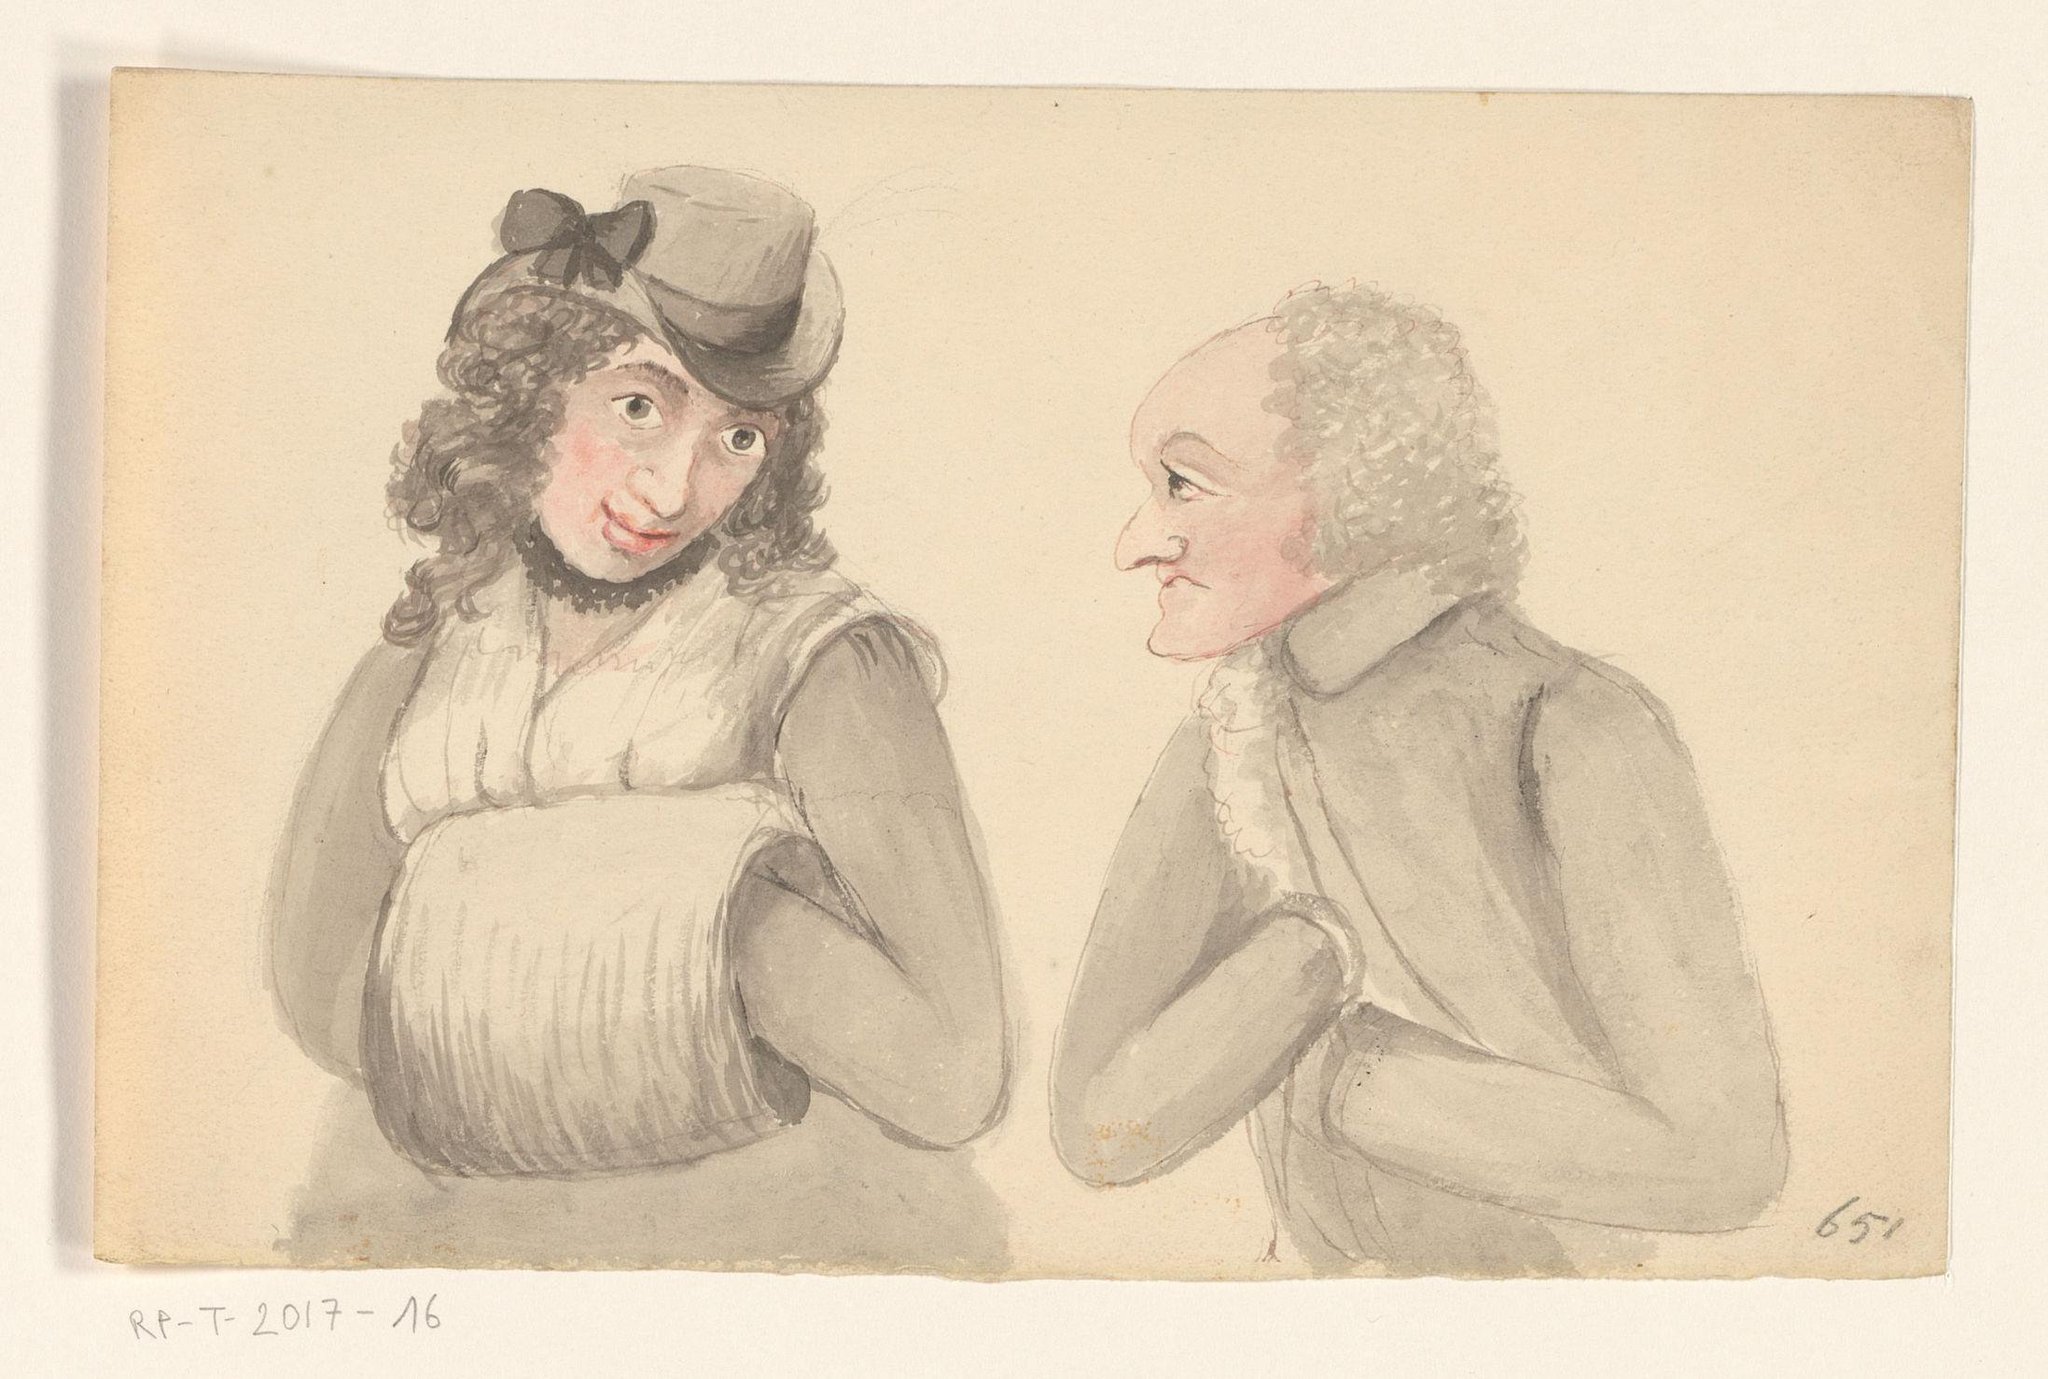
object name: drawing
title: Karikatuur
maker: Anonymous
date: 1750-1850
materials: paper, pencil, watercolor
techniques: pen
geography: england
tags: caricatures (human types), muff, political caricatures and satires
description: Karikatuur van een jonge vrouw met de handen in een mof en een oudere kalende heer.